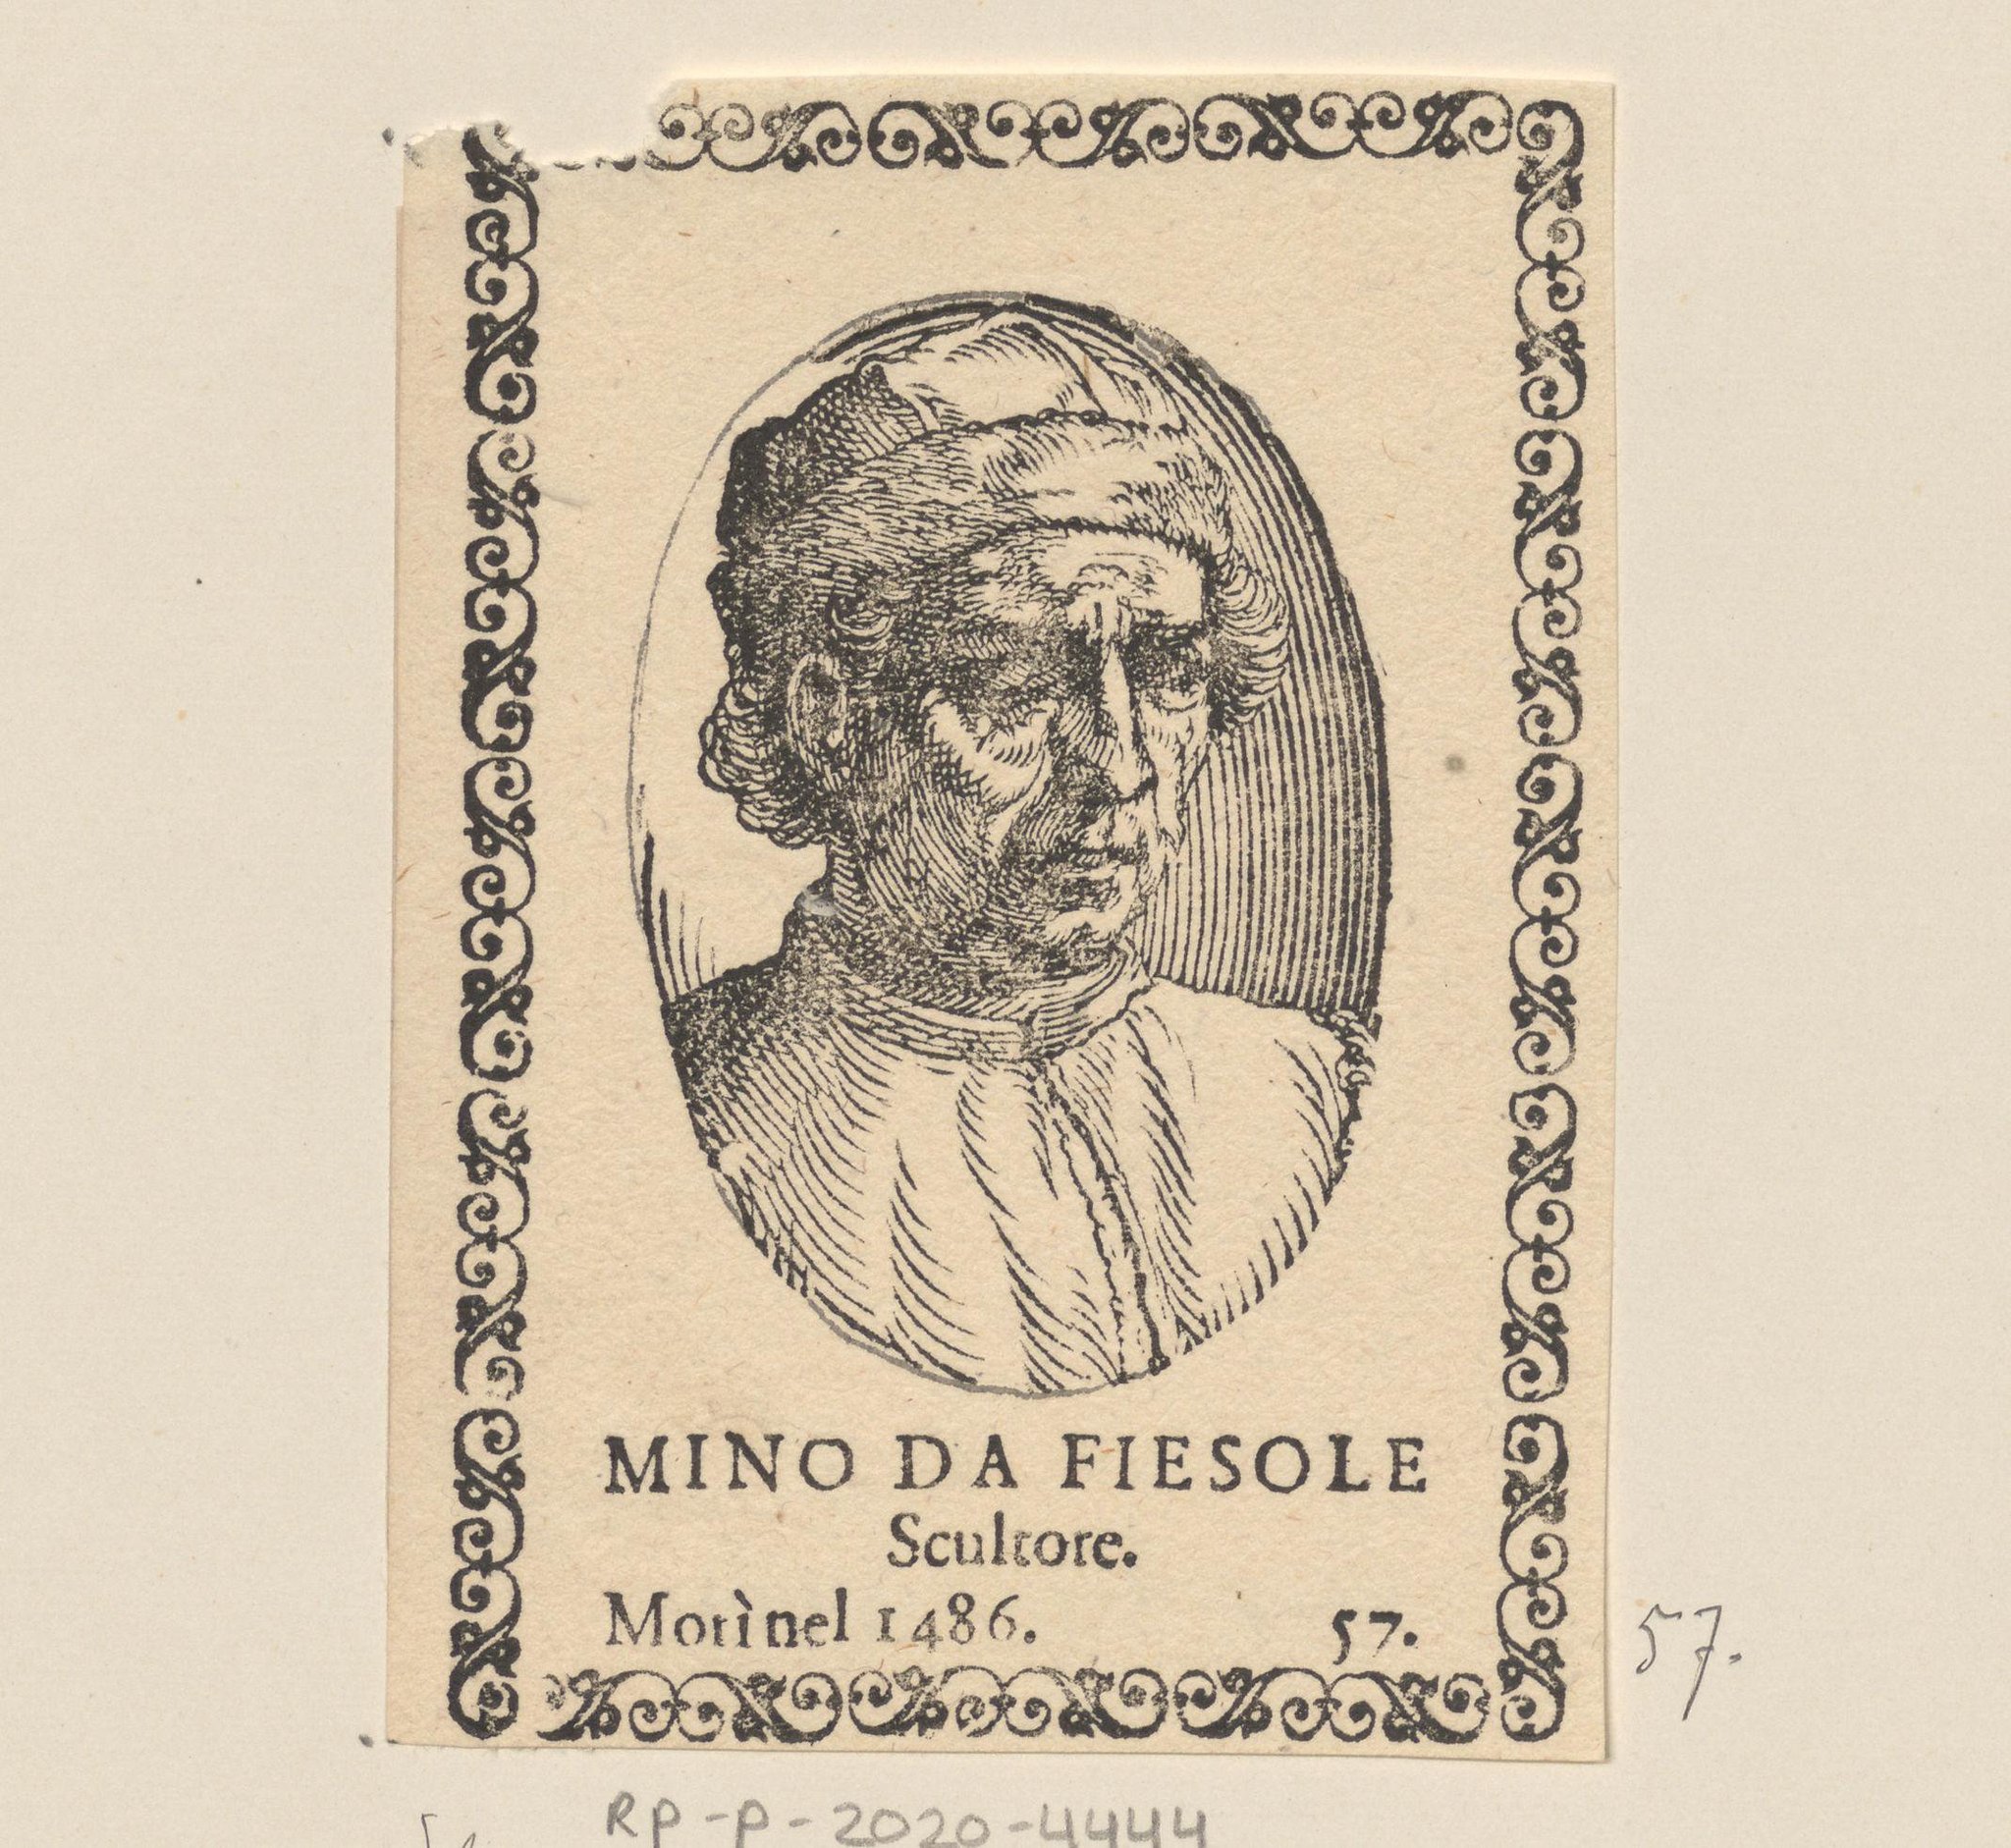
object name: print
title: Portret van Mino da Fiesole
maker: Anonymous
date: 1550-1600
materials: paper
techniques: letterpress printing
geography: italy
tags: sculptor, mino da fiesole, portrait, self-portrait of sculptor, historical persons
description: Prent komt vermoedelijk uit een editie van Vasari's 'Vite'. Vergelijkbare prenten zijn bijvoorbeeld gebruikt in de edities uit 1568 en 1647.